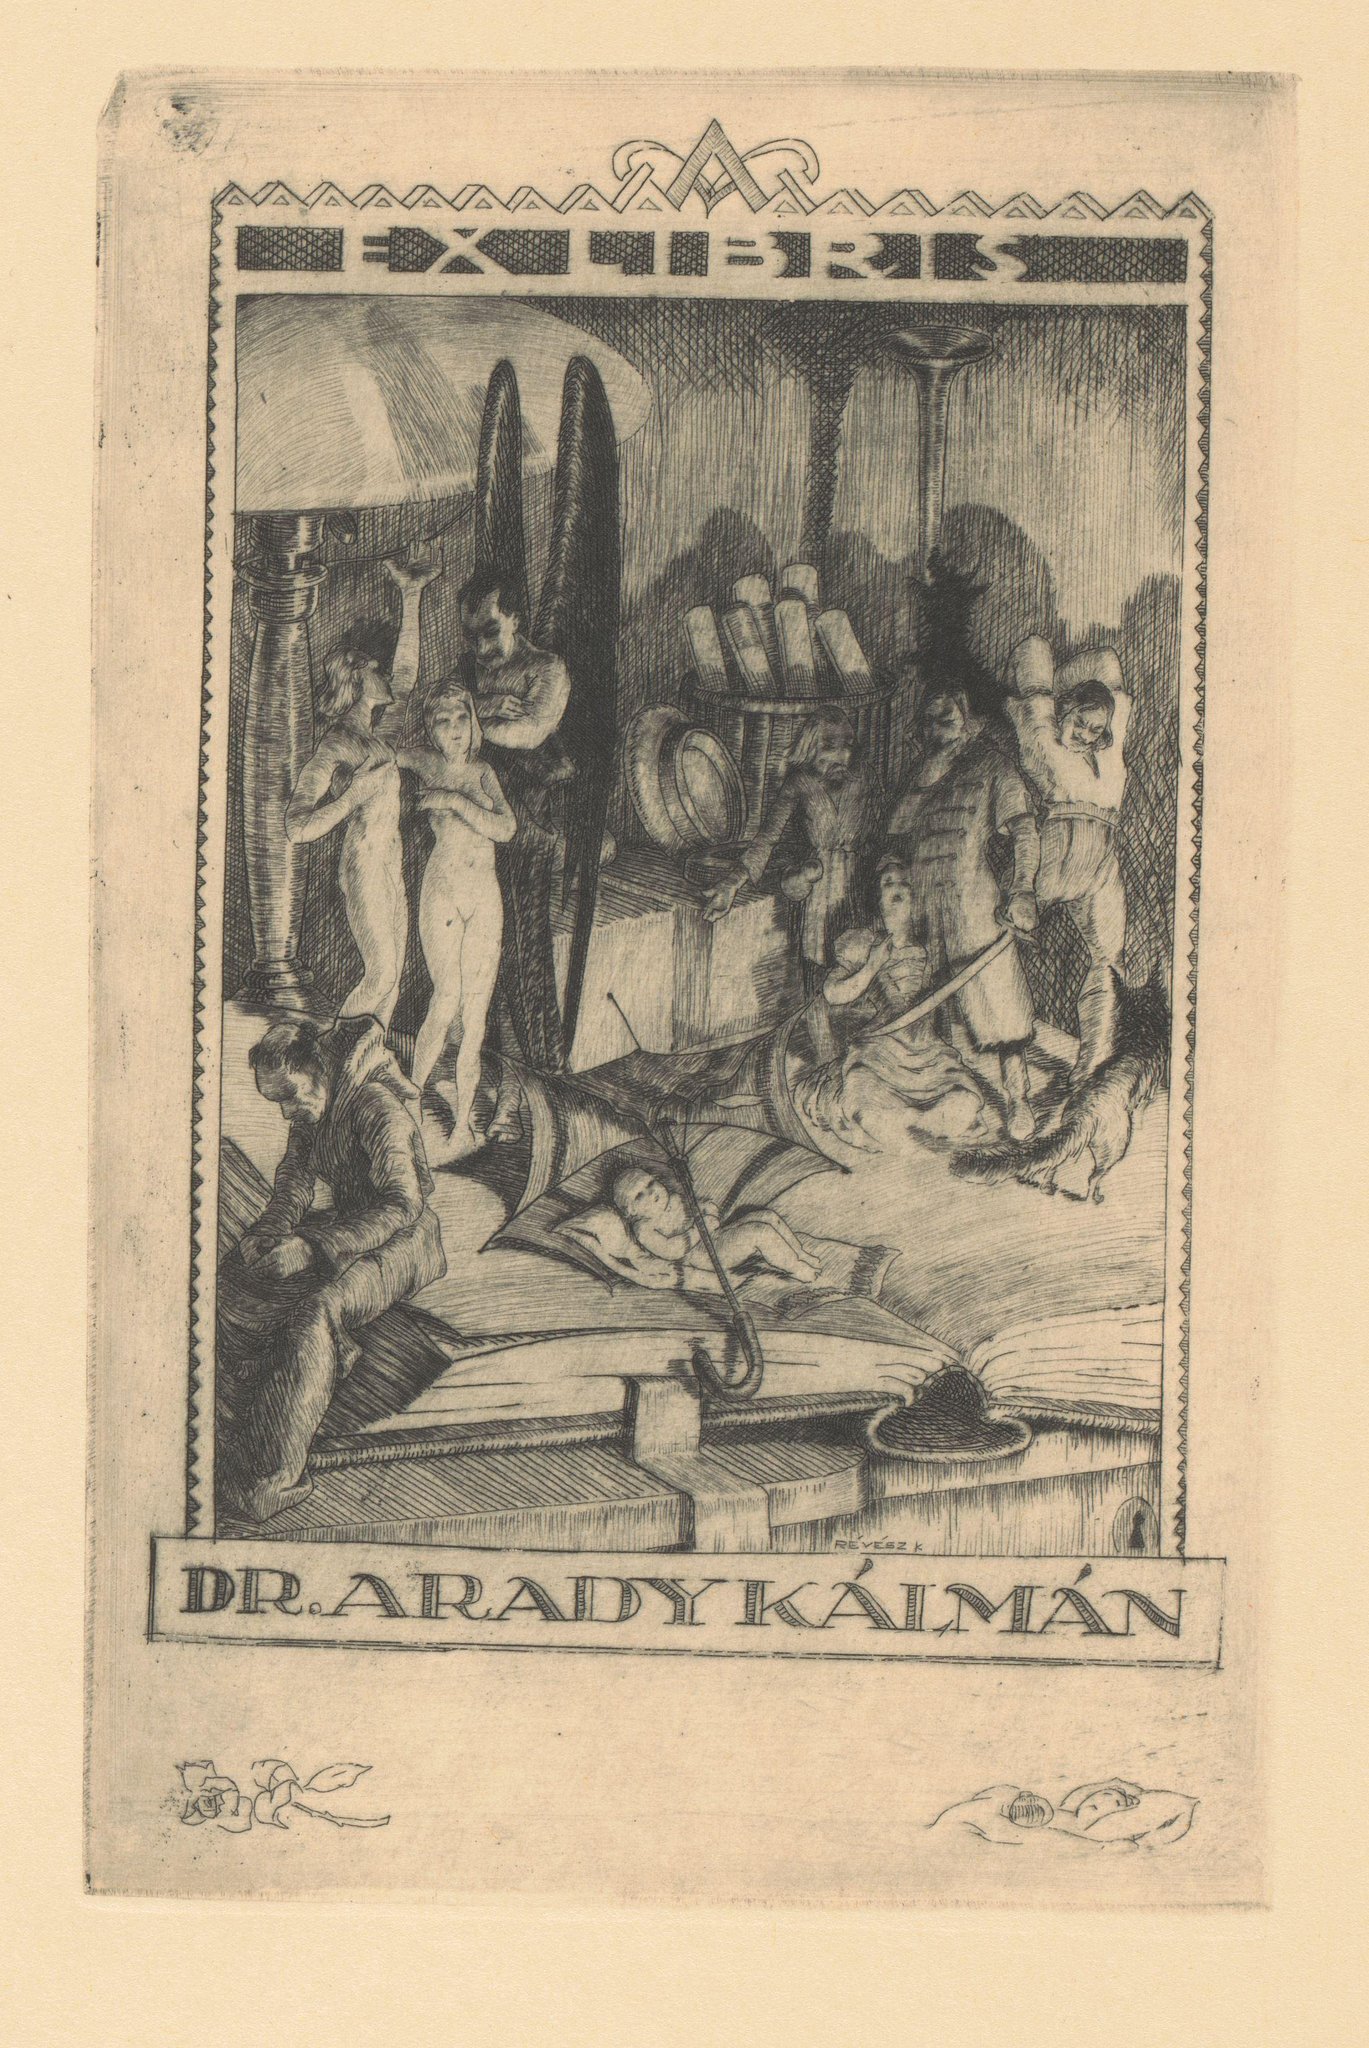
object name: bookplate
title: Ex libris dr. Arady Kálmán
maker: kornél révész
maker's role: print maker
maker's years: 1885-1944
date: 1903-1936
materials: paper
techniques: drypoint, etching, intaglio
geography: hungary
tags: woman (showing herself) undressed, quasi-nude, book, umbrella, infant, baby, angels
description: Prent is deel van een catalogus met 13 ingebonden objecten en twee tekstbladen. Catalogus is deel van een omslag met 64 objecten op 34 opzetvellen en een tekstblad.